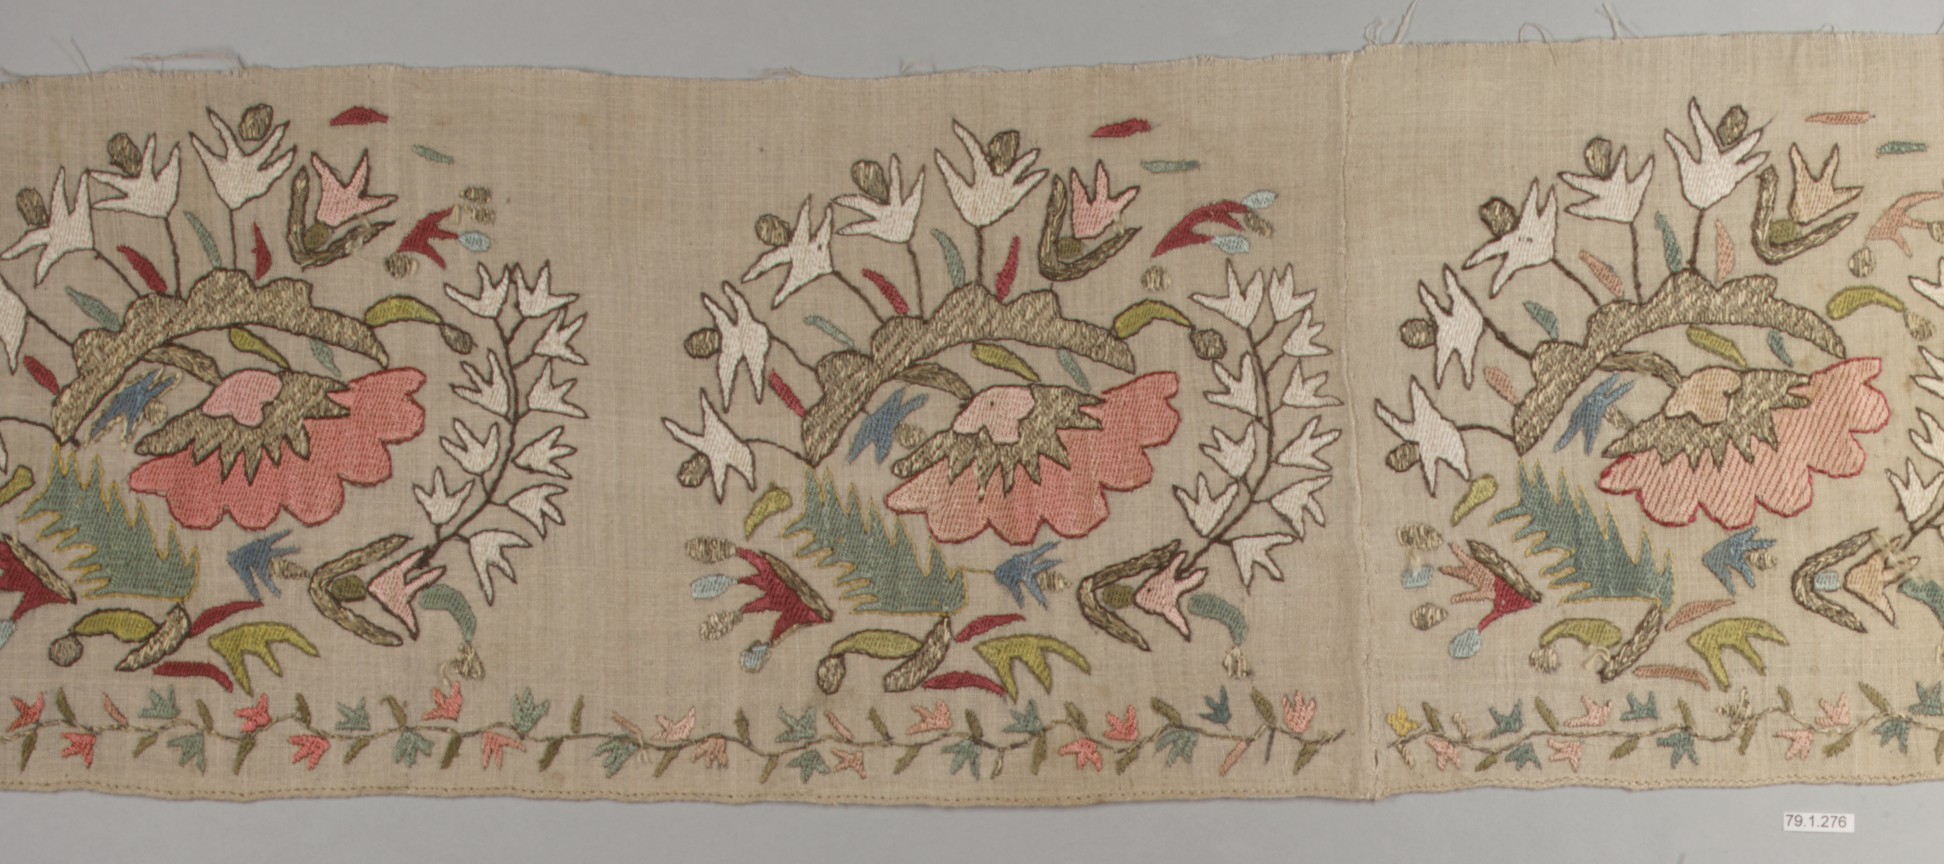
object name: textile fragment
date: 1801-1833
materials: linen, metal thread, silk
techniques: embroidery, weave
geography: greece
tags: flowers